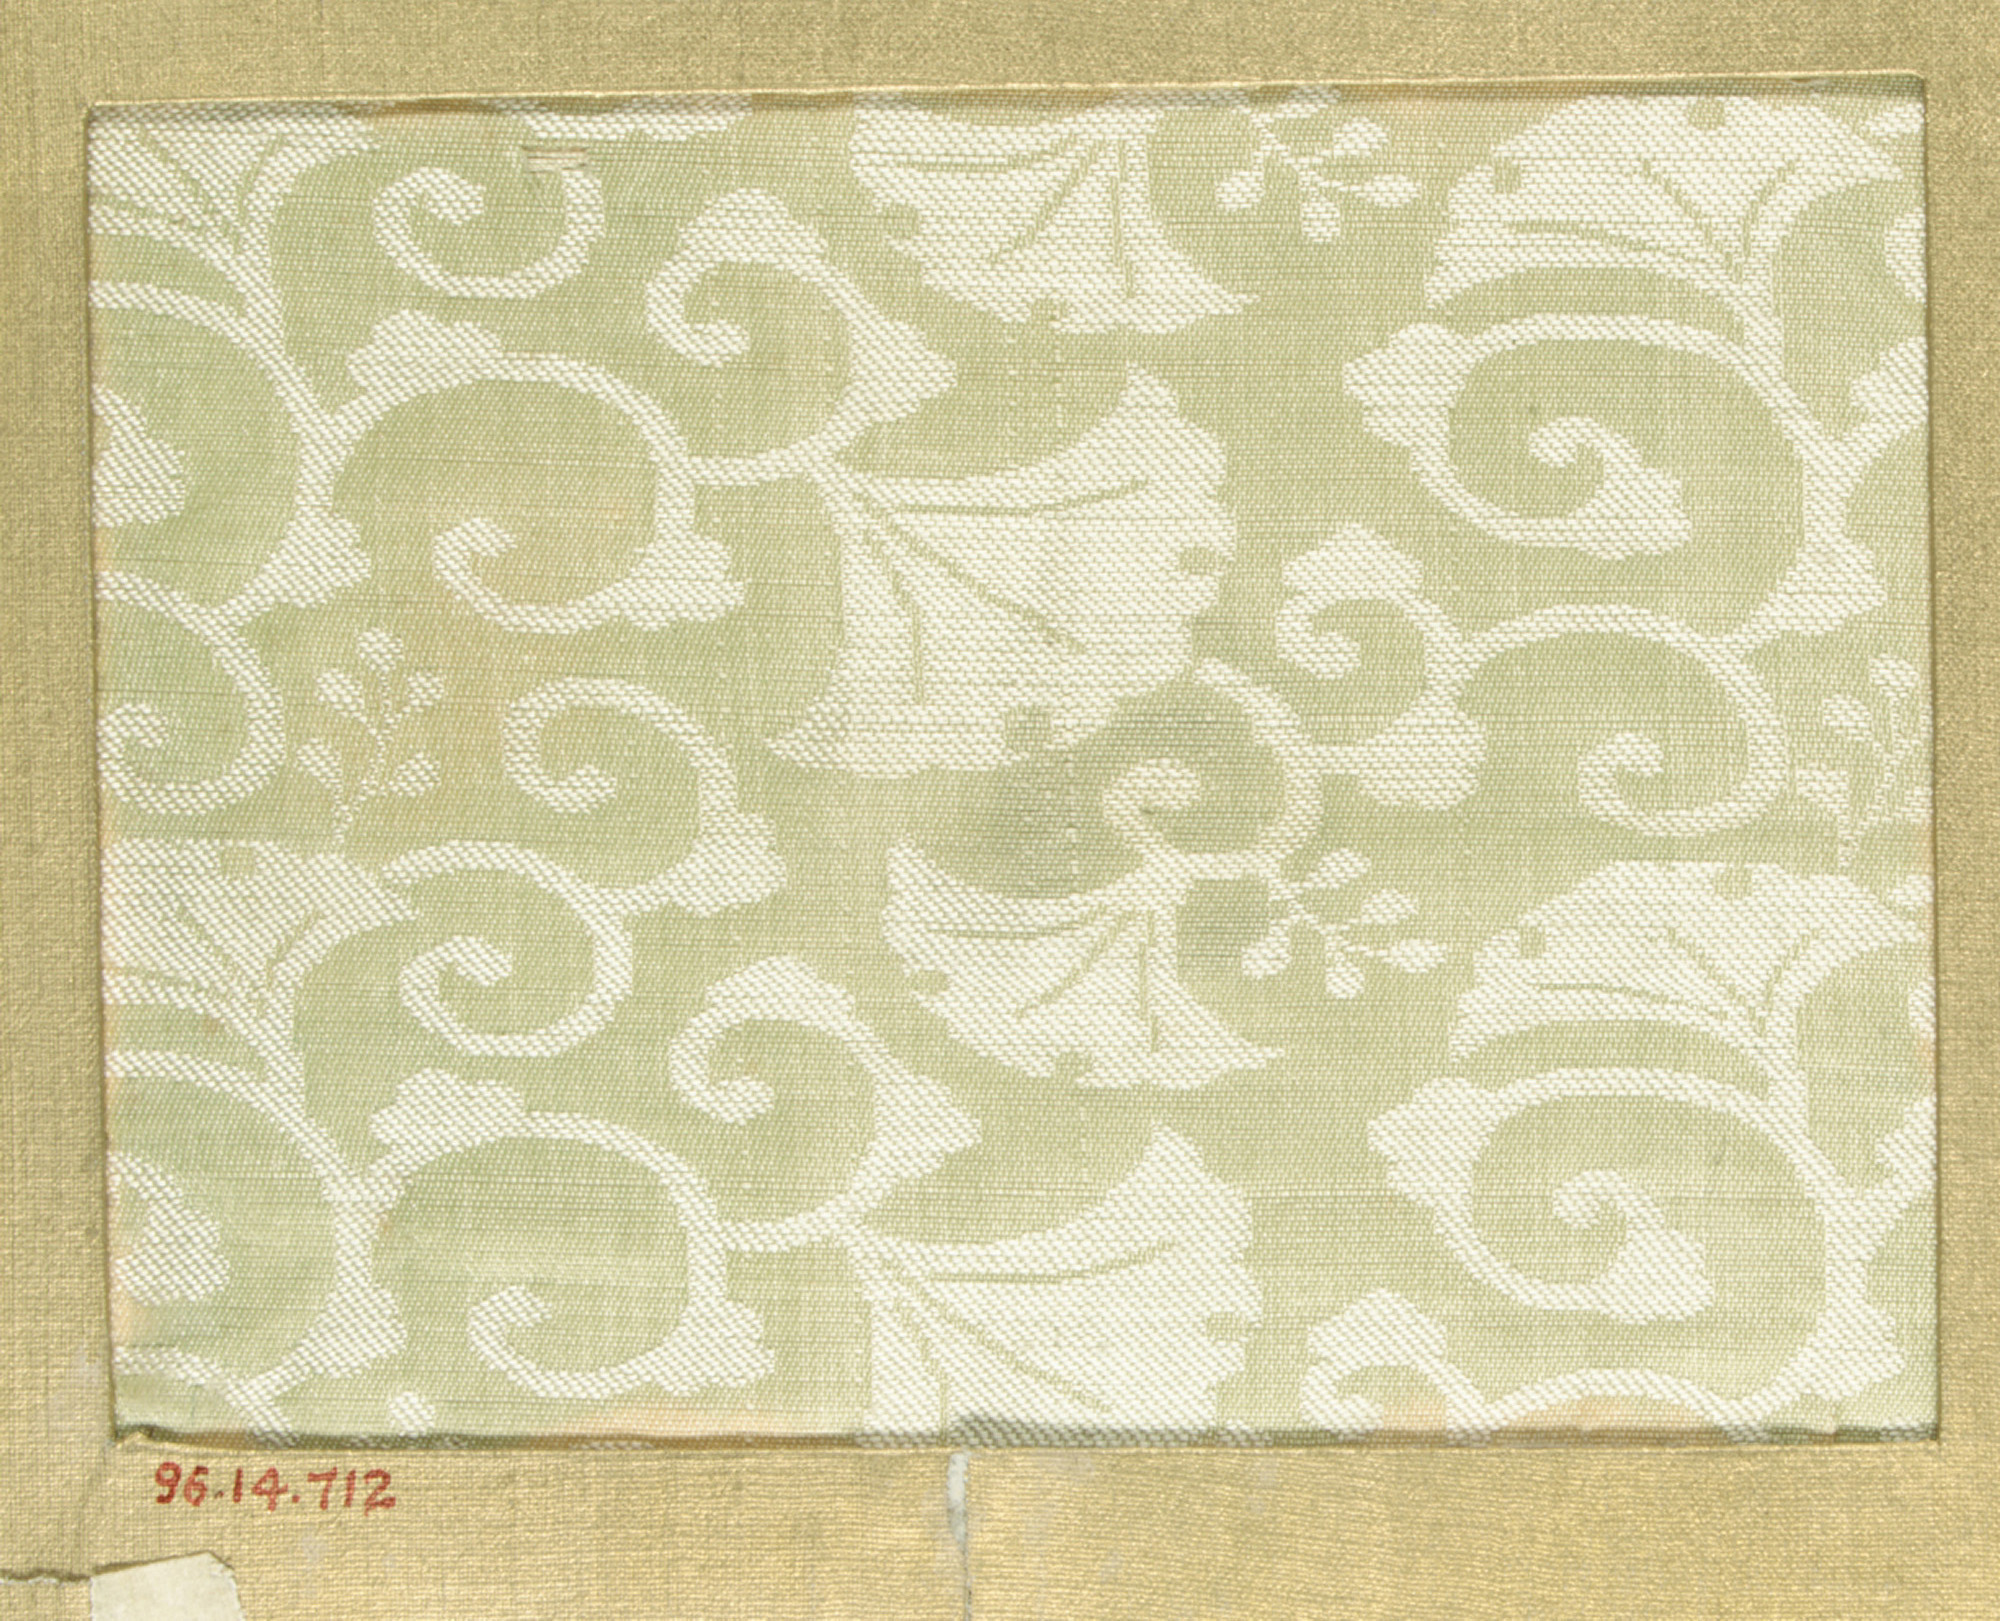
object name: piece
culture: japanese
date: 1701-1900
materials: silk